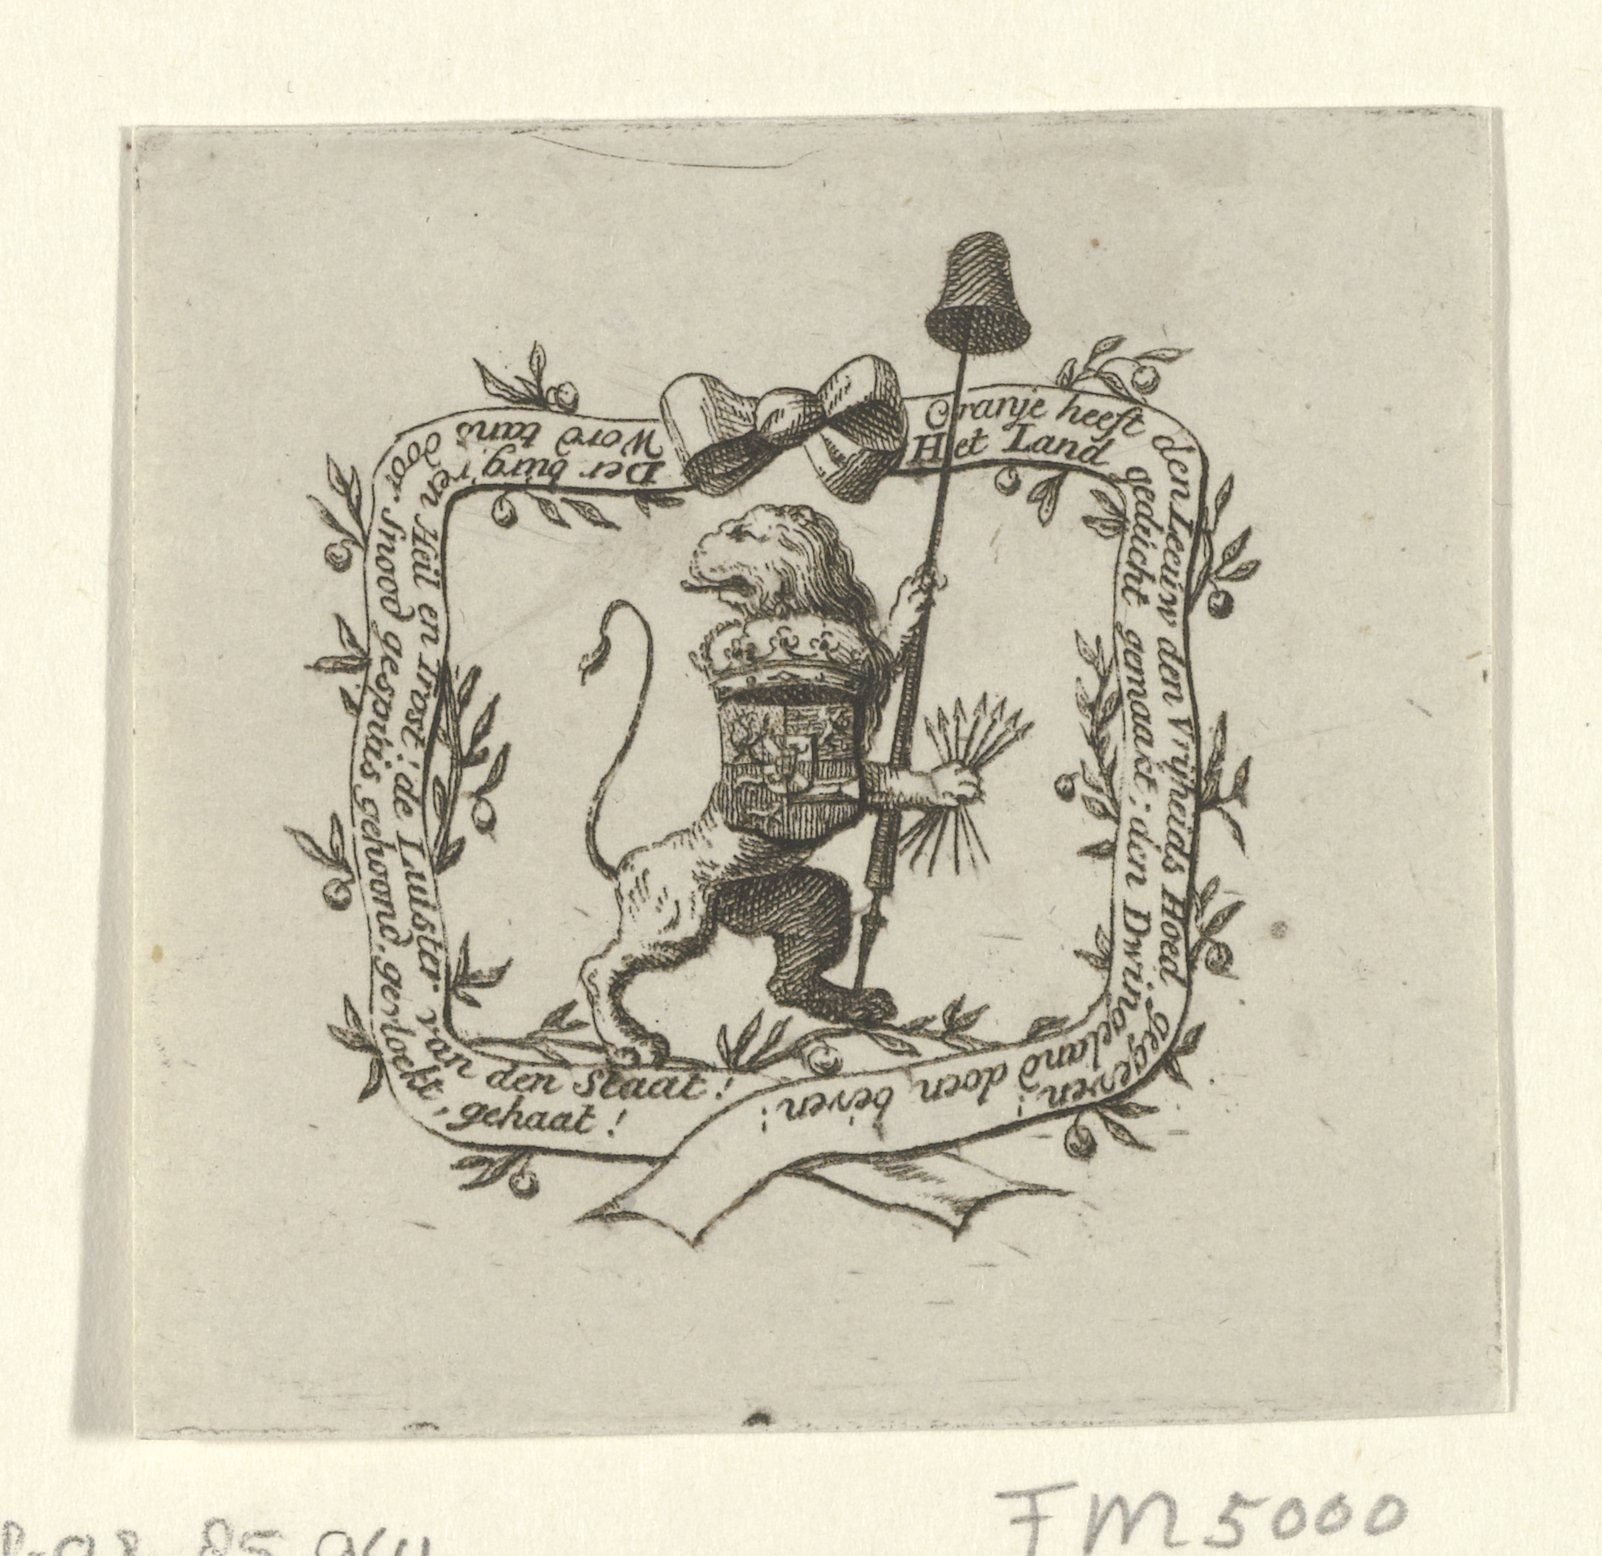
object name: print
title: Vignet met de Nederlandse Leeuw met vrijheidslans, 1787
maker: Anonymous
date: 1787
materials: paper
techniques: etching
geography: northern netherlands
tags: herstel van stadhouder willem v (1787)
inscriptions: collector's mark: Lugt 2228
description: Vignet met de Nederlandse Leeuw met vrijheidslans met vrijheidshoed, 1787. Om de leeuw een gestrikte lint met tekst versierd met oranjeappels. Allegorie op het herstel van stadhouder Willem V in 1787.